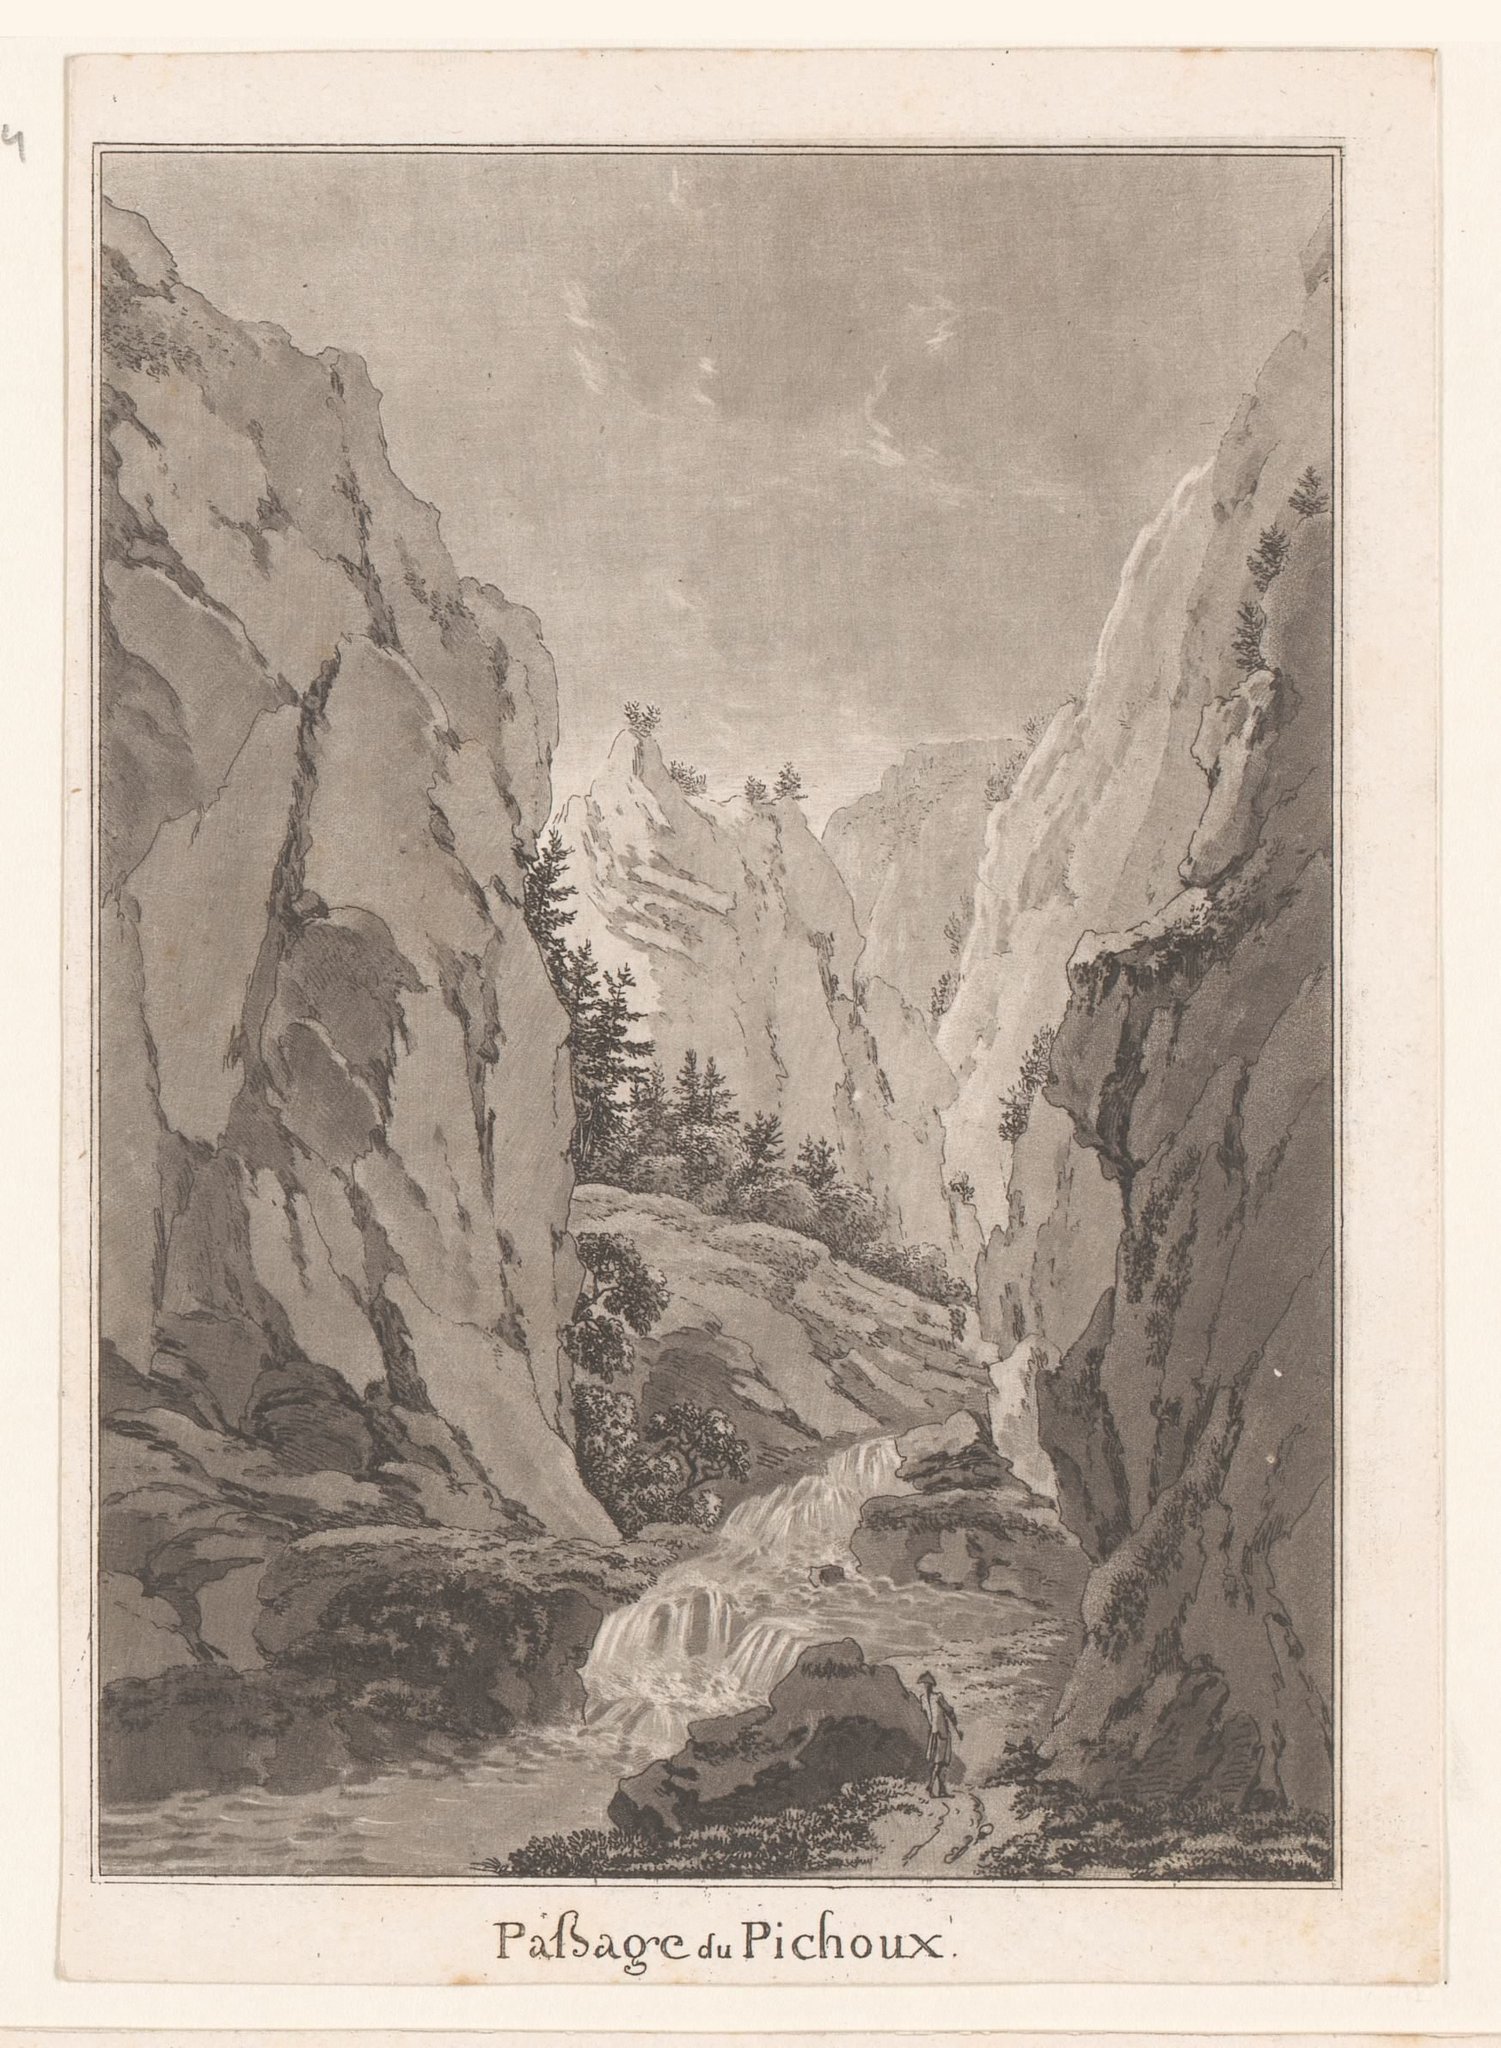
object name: print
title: Gezicht op de passage van Pichoux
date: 1810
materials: paper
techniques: aquatint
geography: amsterdam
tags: road, path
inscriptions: collector's mark: Lugt 2228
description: Prent ook gebruikt in: Promenade Pittoresque dans l'évêché de bâle aux bords de la Birs (...). Amsterdam: T.B. Groebe, 1710.